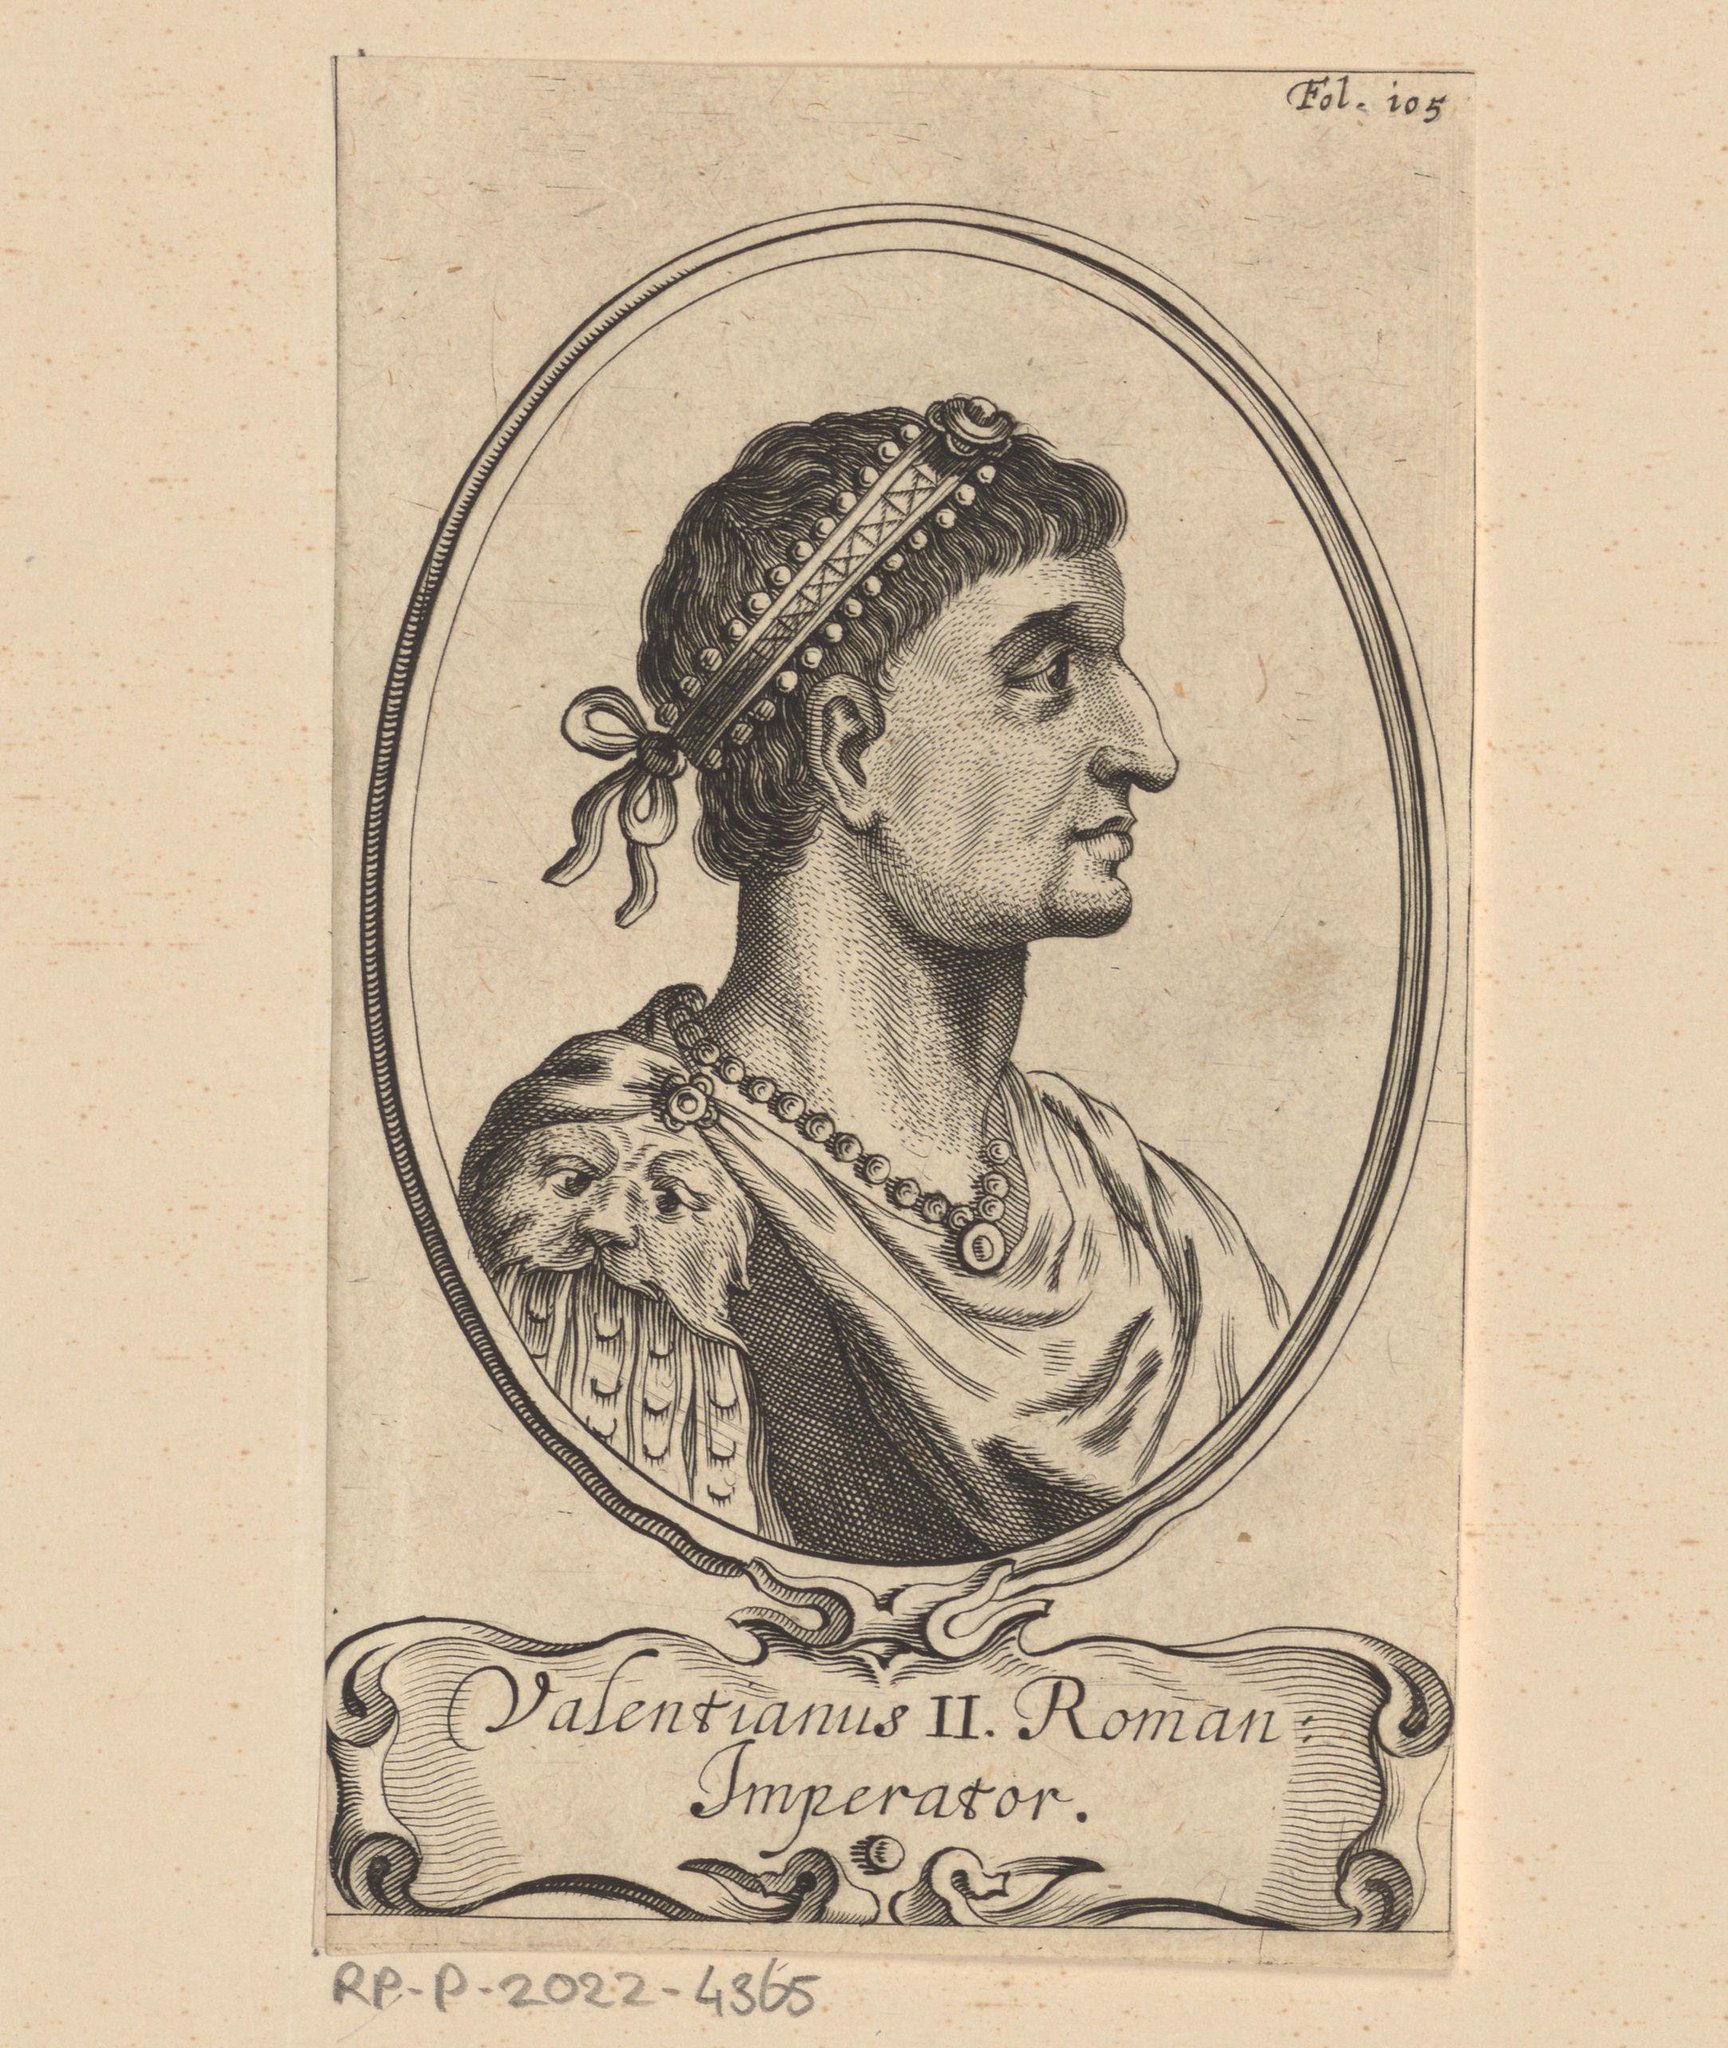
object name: print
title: Portret van keizer Valentinianus II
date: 1656-1659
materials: paper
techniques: engraving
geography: northern netherlands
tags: historical persons, emperor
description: Prent gebruikt in: Bos, Lambert van den. Het konincklyk treur-toonneel, ofte op- en ondergangh der keyseren, koningen en vorsten (...). Dordrecht: Jacobus Savry, 1656. Prent ook gebruikt in de 1659-editie.